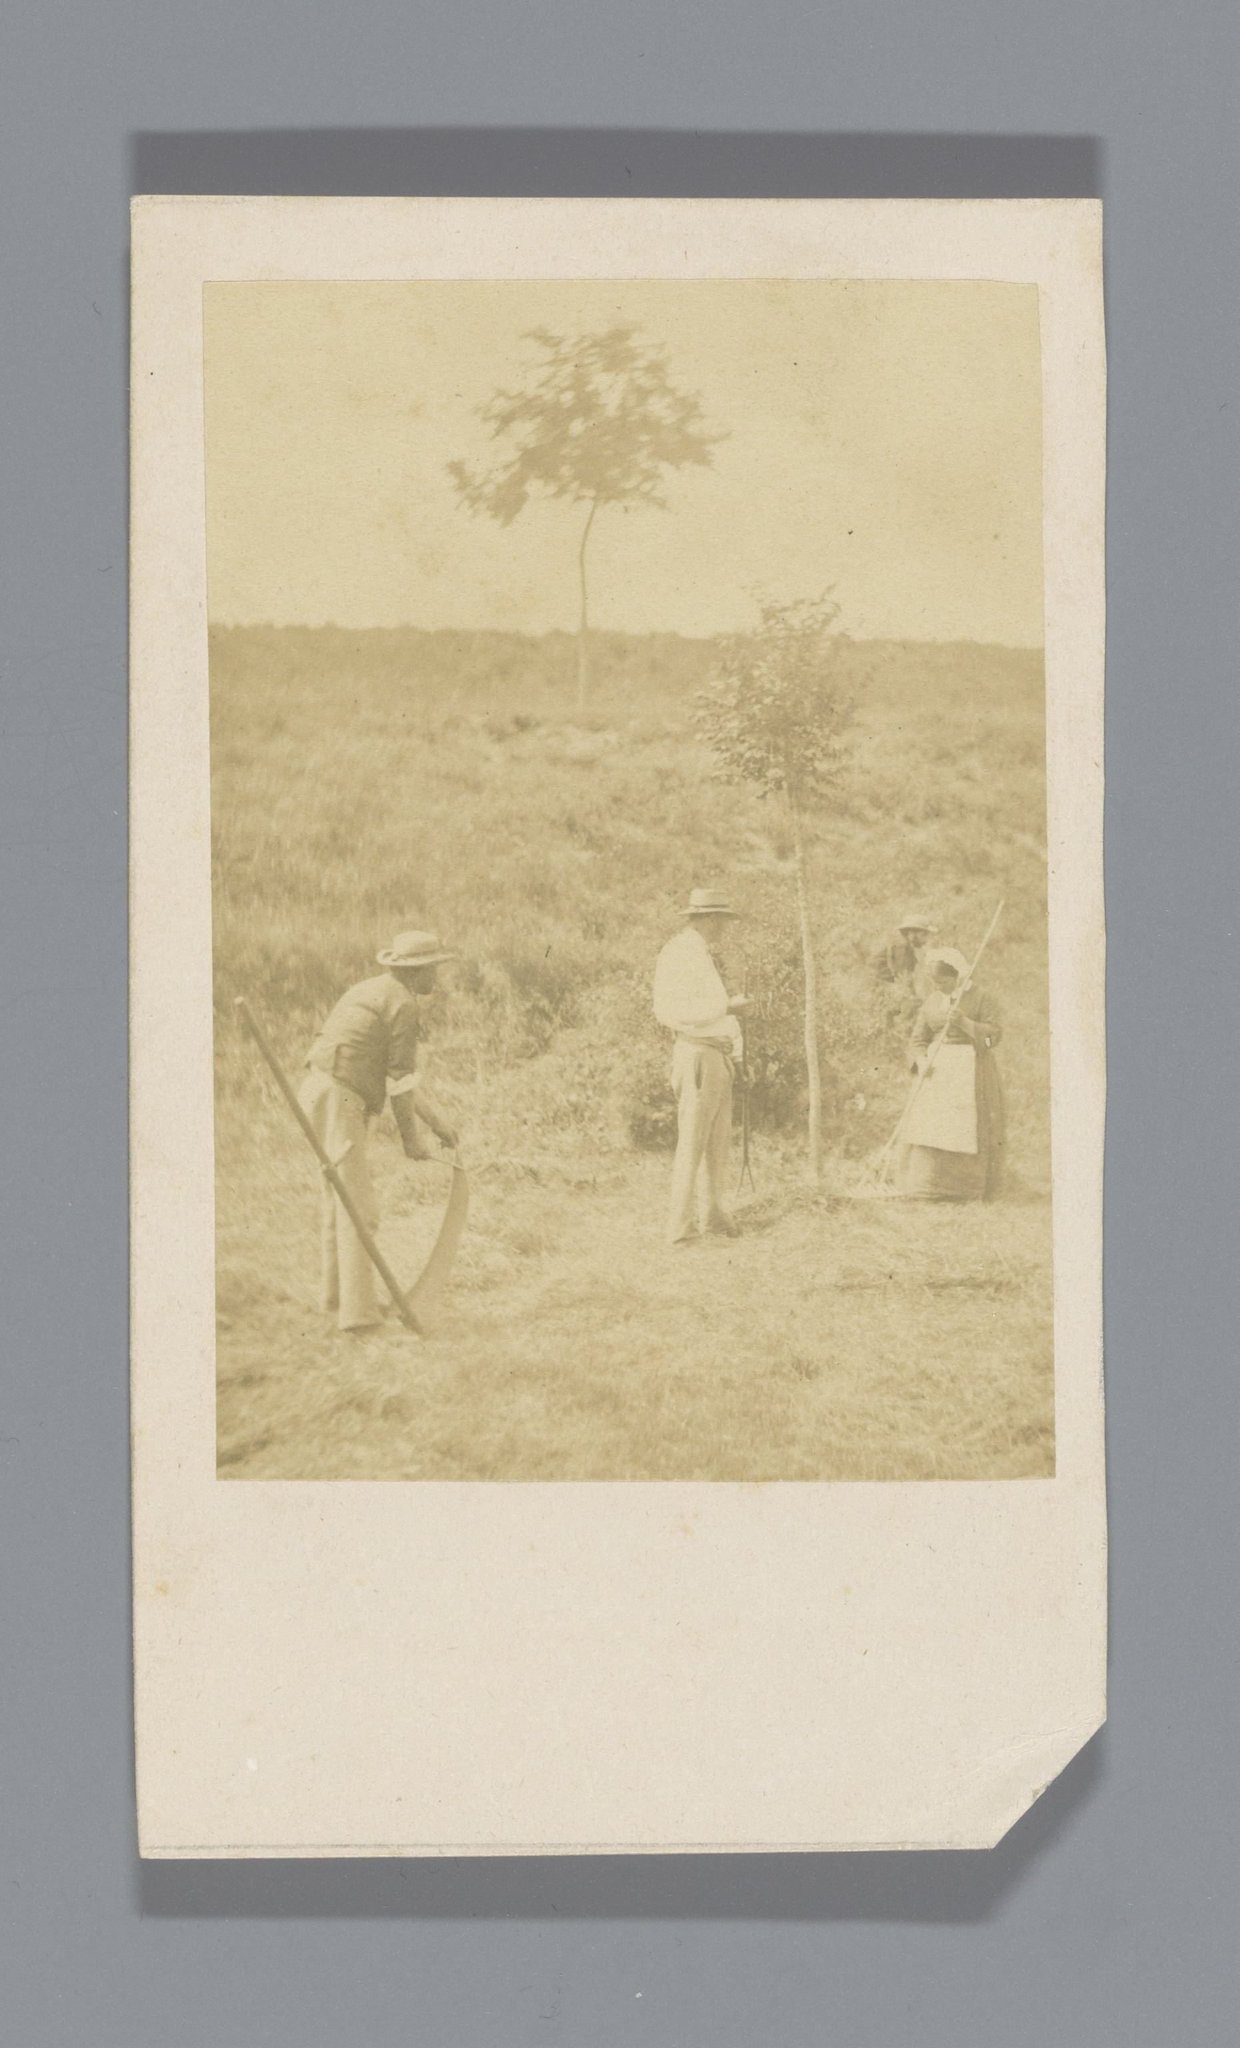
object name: carte de visite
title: Landarbeiders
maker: Anonymous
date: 1865-1870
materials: cardboard, paper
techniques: albumen print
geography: france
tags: farmers, working class, labourers, france